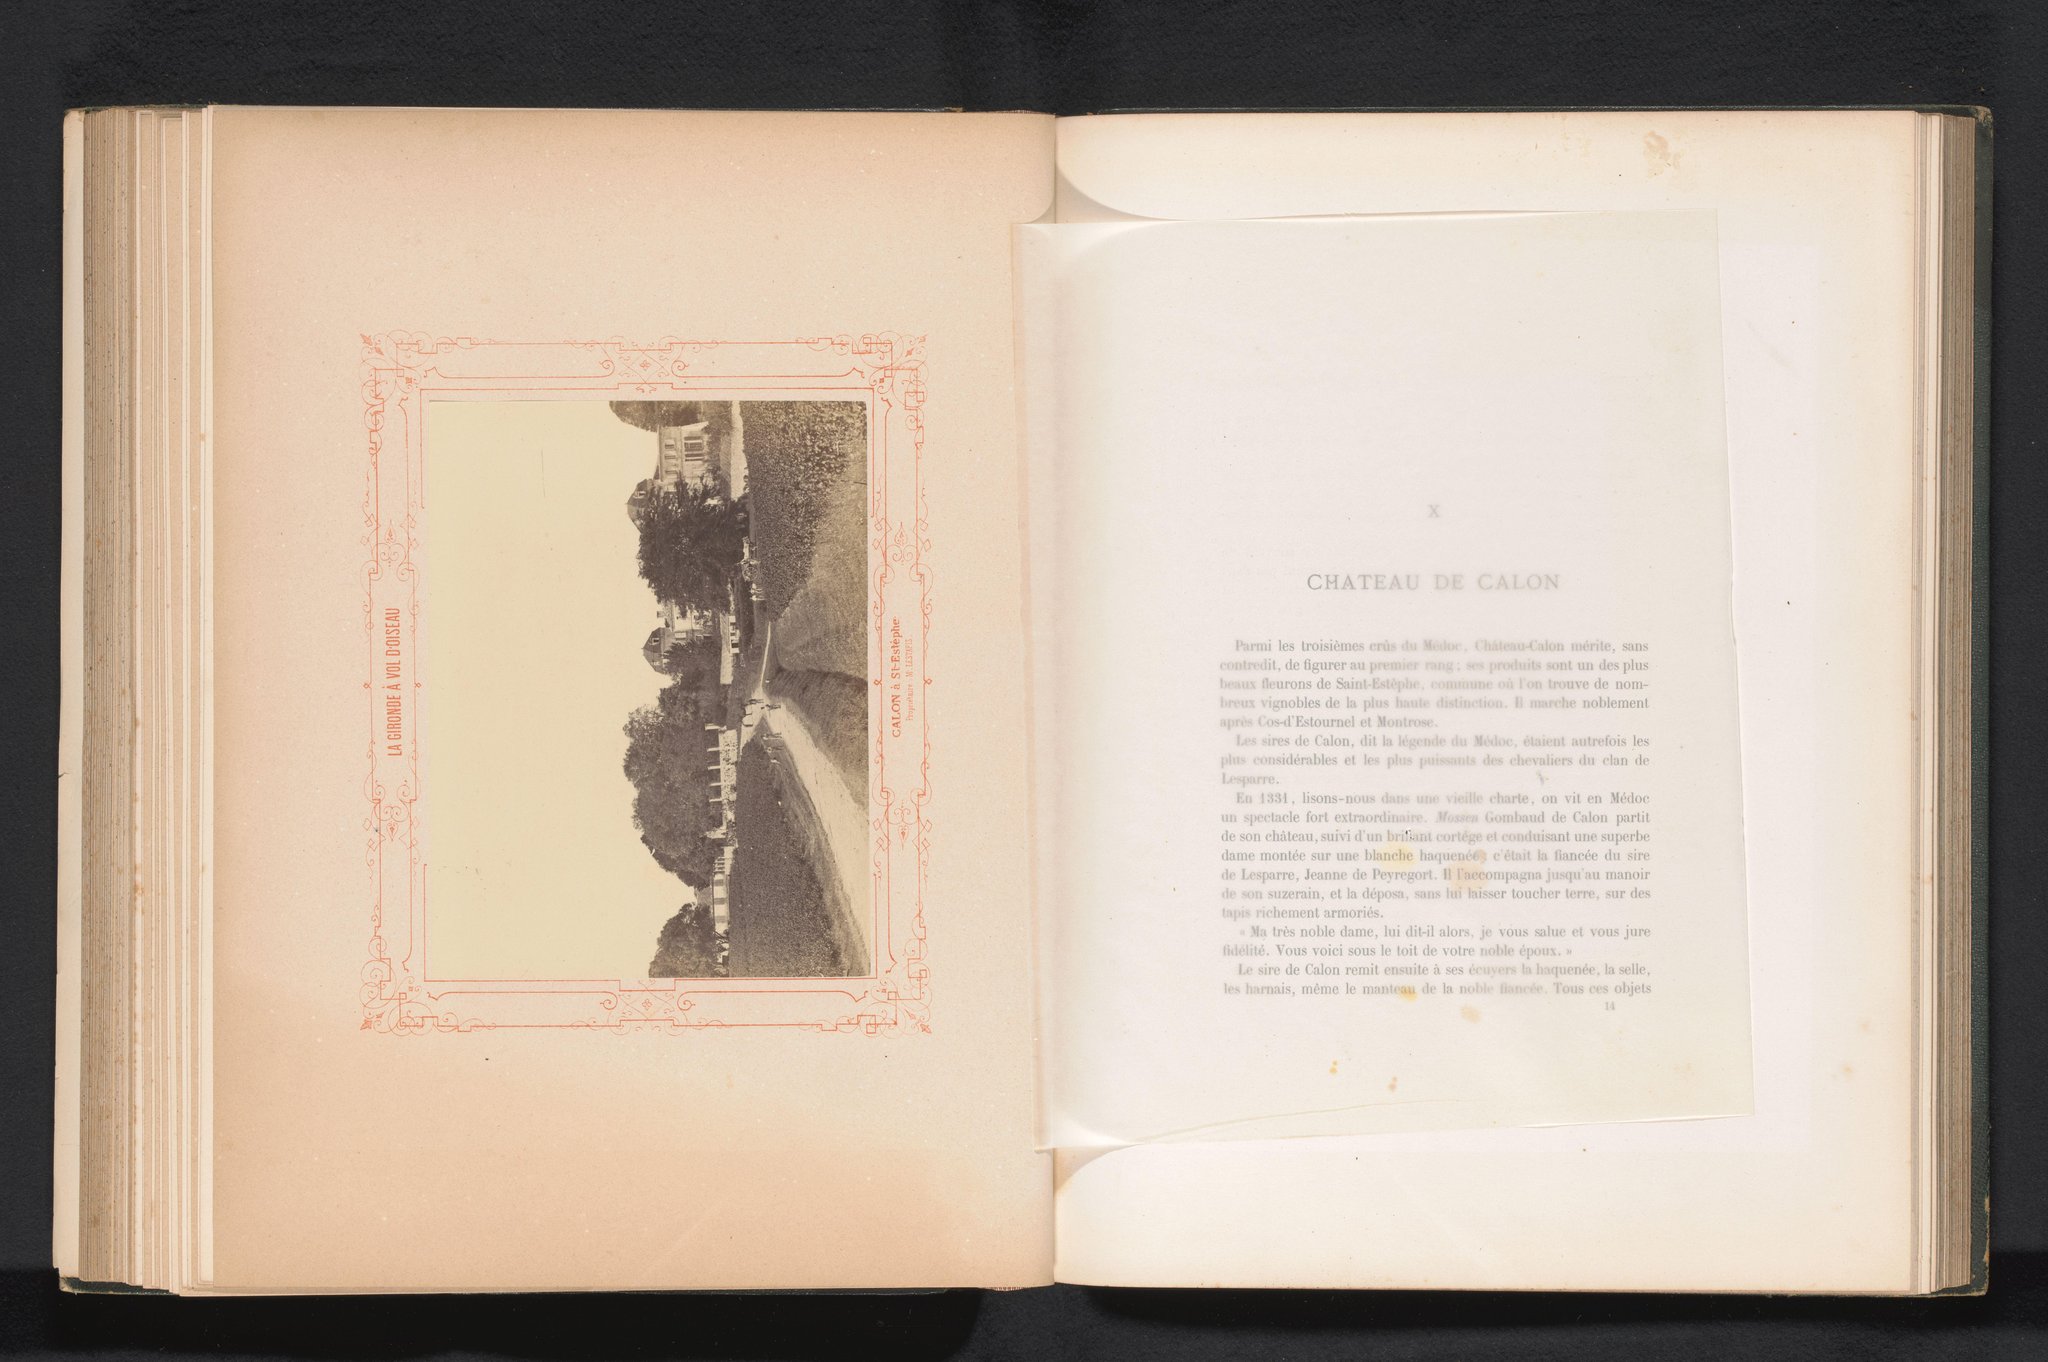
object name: page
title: Calon à St-Estèphe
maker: alfred danflou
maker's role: fotograaf, schrijver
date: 1862-1867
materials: photographic support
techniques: albumen print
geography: saint-estèphe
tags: castle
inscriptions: inscription: ‘propriétaire: M. LESTAPIS.’